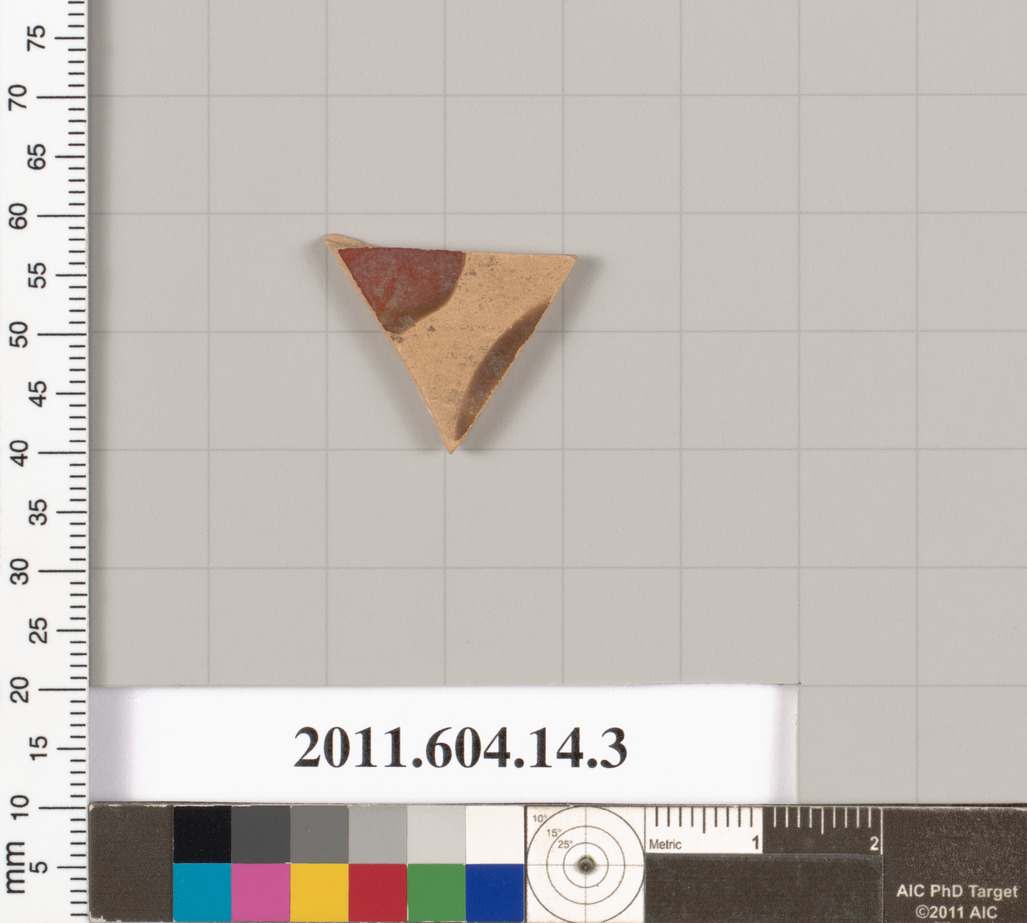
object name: undetermined closed shape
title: Terracotta fragment of a closed shape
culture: unknown fabric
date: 600-501 BCE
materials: terracotta